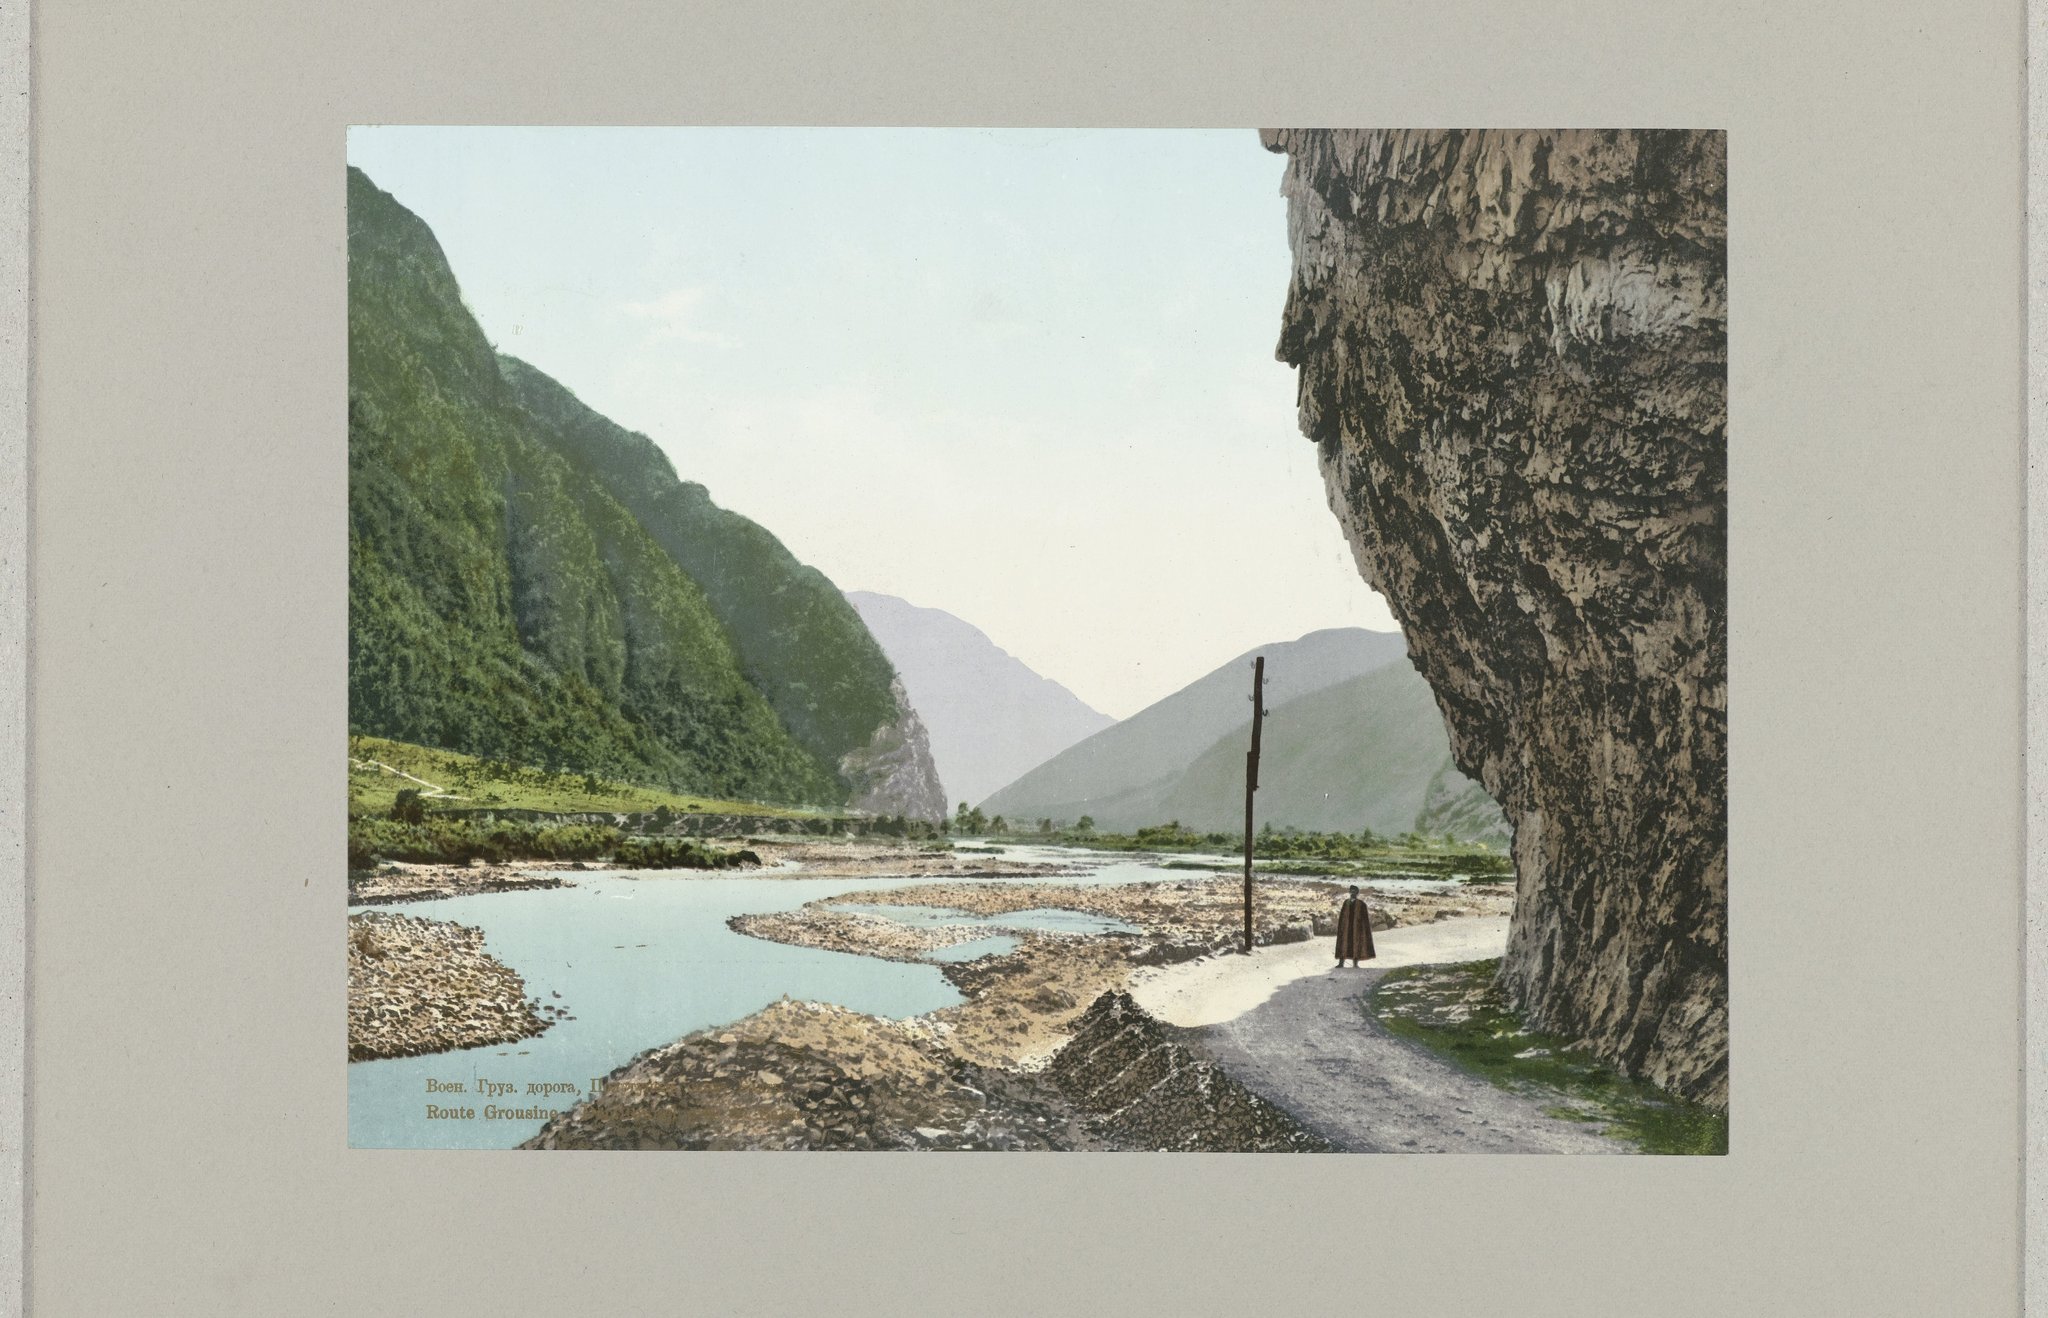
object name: photograph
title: Weg in kloof nabij Balta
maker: Anonymous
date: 1895-1915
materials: cardboard, paper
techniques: photolithography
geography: mtskheta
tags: mtskheta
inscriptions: annotation: ‘41 idem.’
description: Weg tussen rivier en rotswand, linksonder staat de titel in het Russisch en in het Frans.